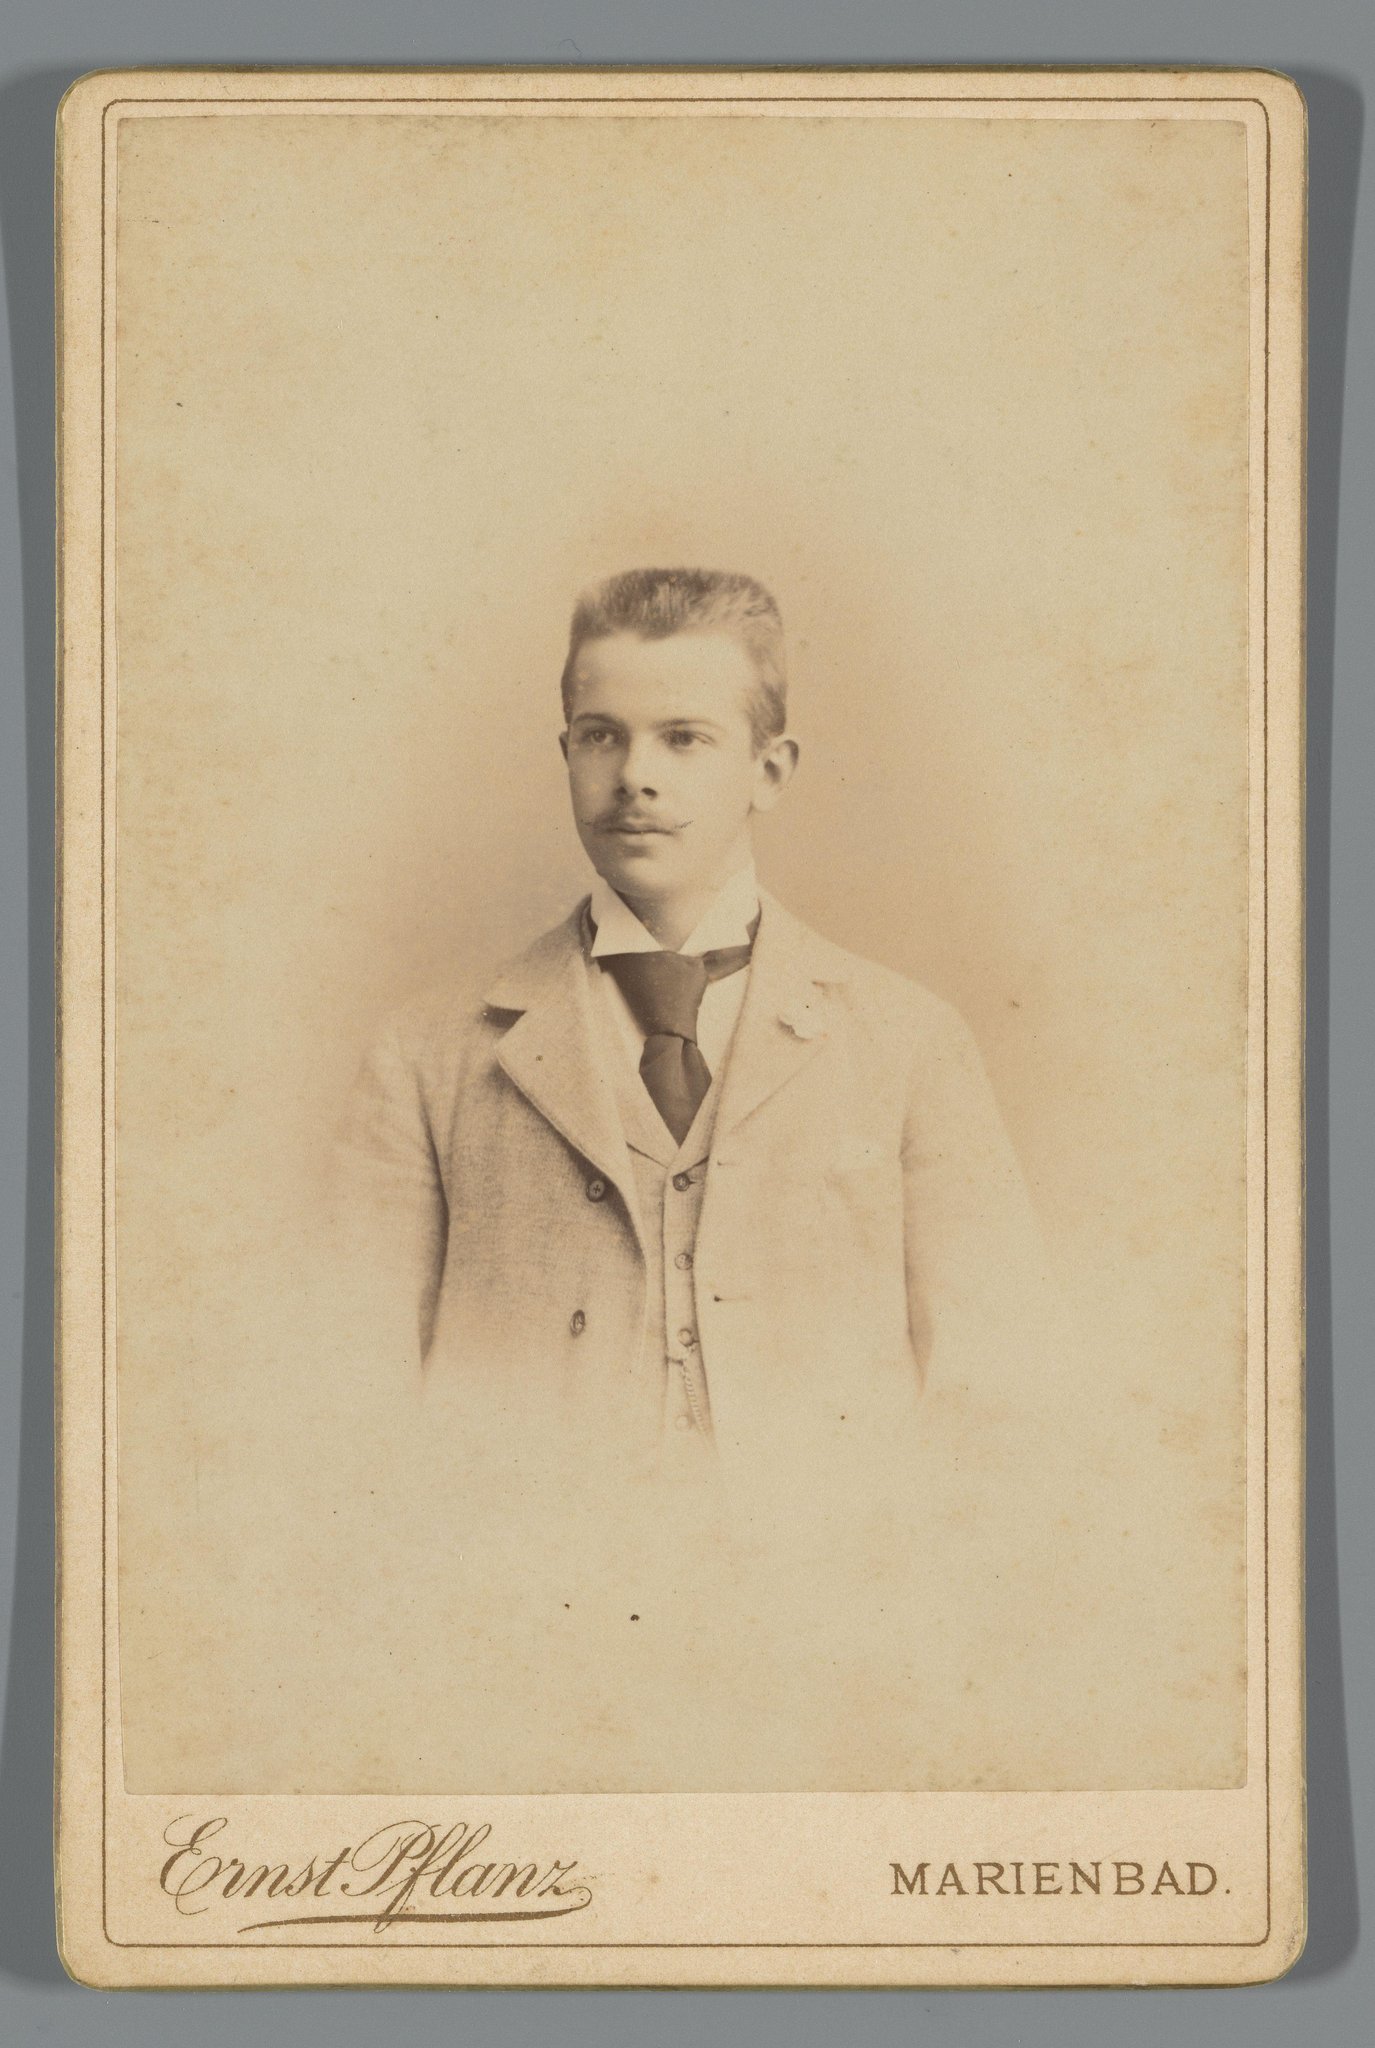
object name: cabinet photograph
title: Portret van Hendrik Herman van den Berg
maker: ernst pflanz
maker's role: painter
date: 1890-1910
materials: cardboard, photographic support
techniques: albumen print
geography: marienbad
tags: batavia, amsterdam, hendrik herman van den berg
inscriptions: inscription: ‘Ernst Pflanz MARIENBAD.’, inscription: ‘H. v.d Berg’